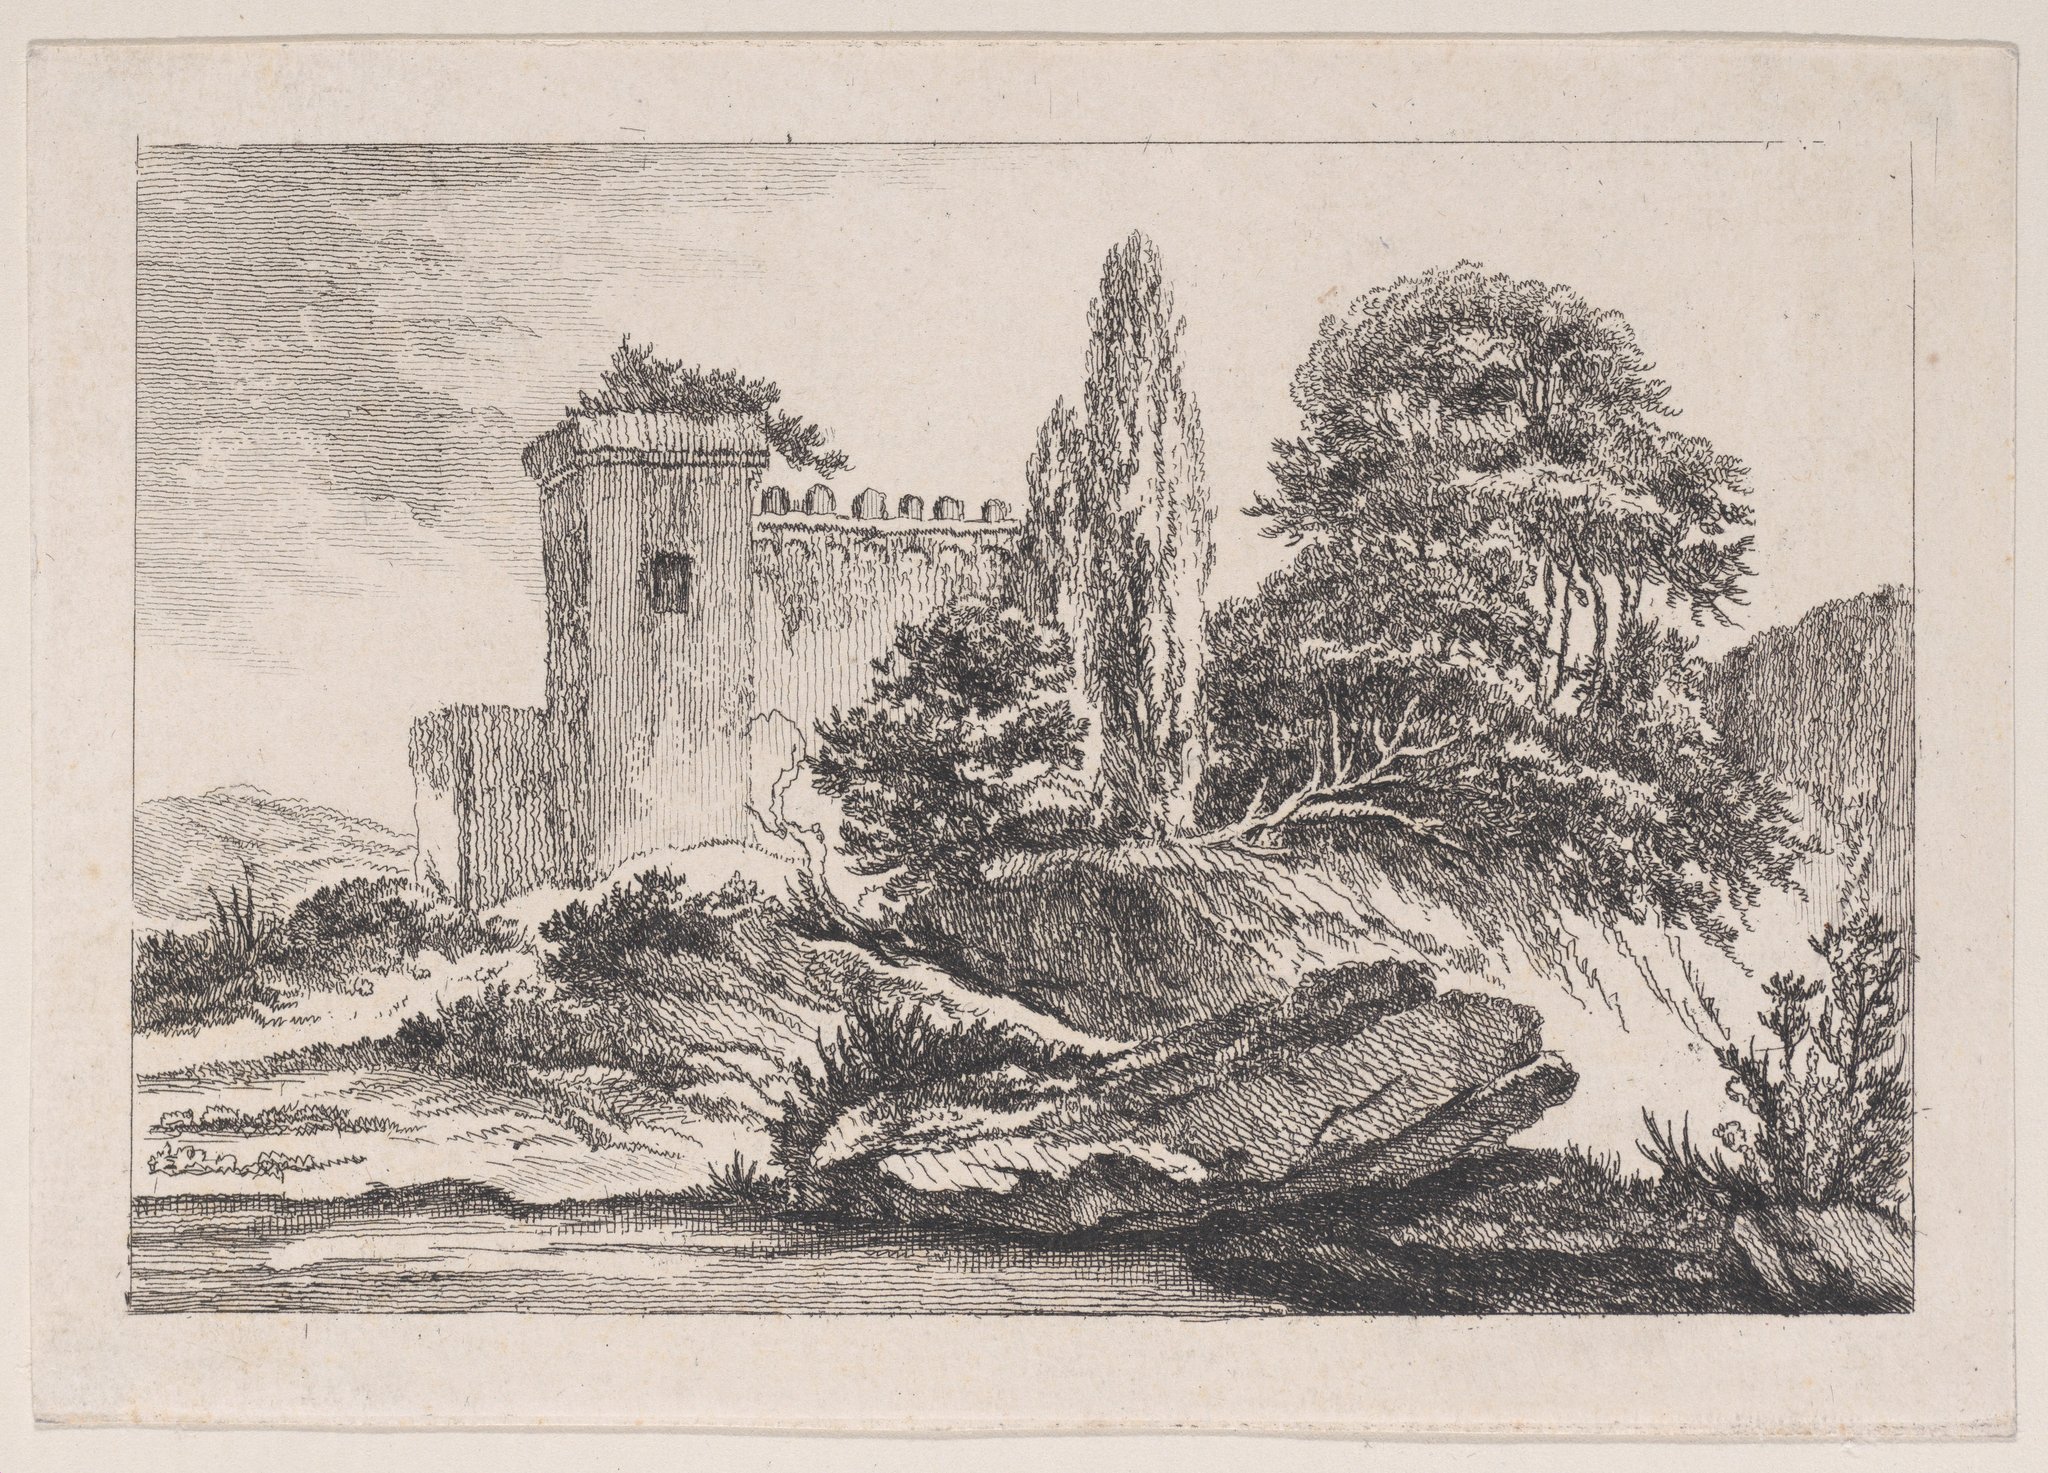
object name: print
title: Rustic Landscape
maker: louis philippe joseph, duc de chartres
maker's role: artist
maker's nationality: french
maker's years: 1726-1785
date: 1701-1800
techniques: etching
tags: buildings,landscapes,trees